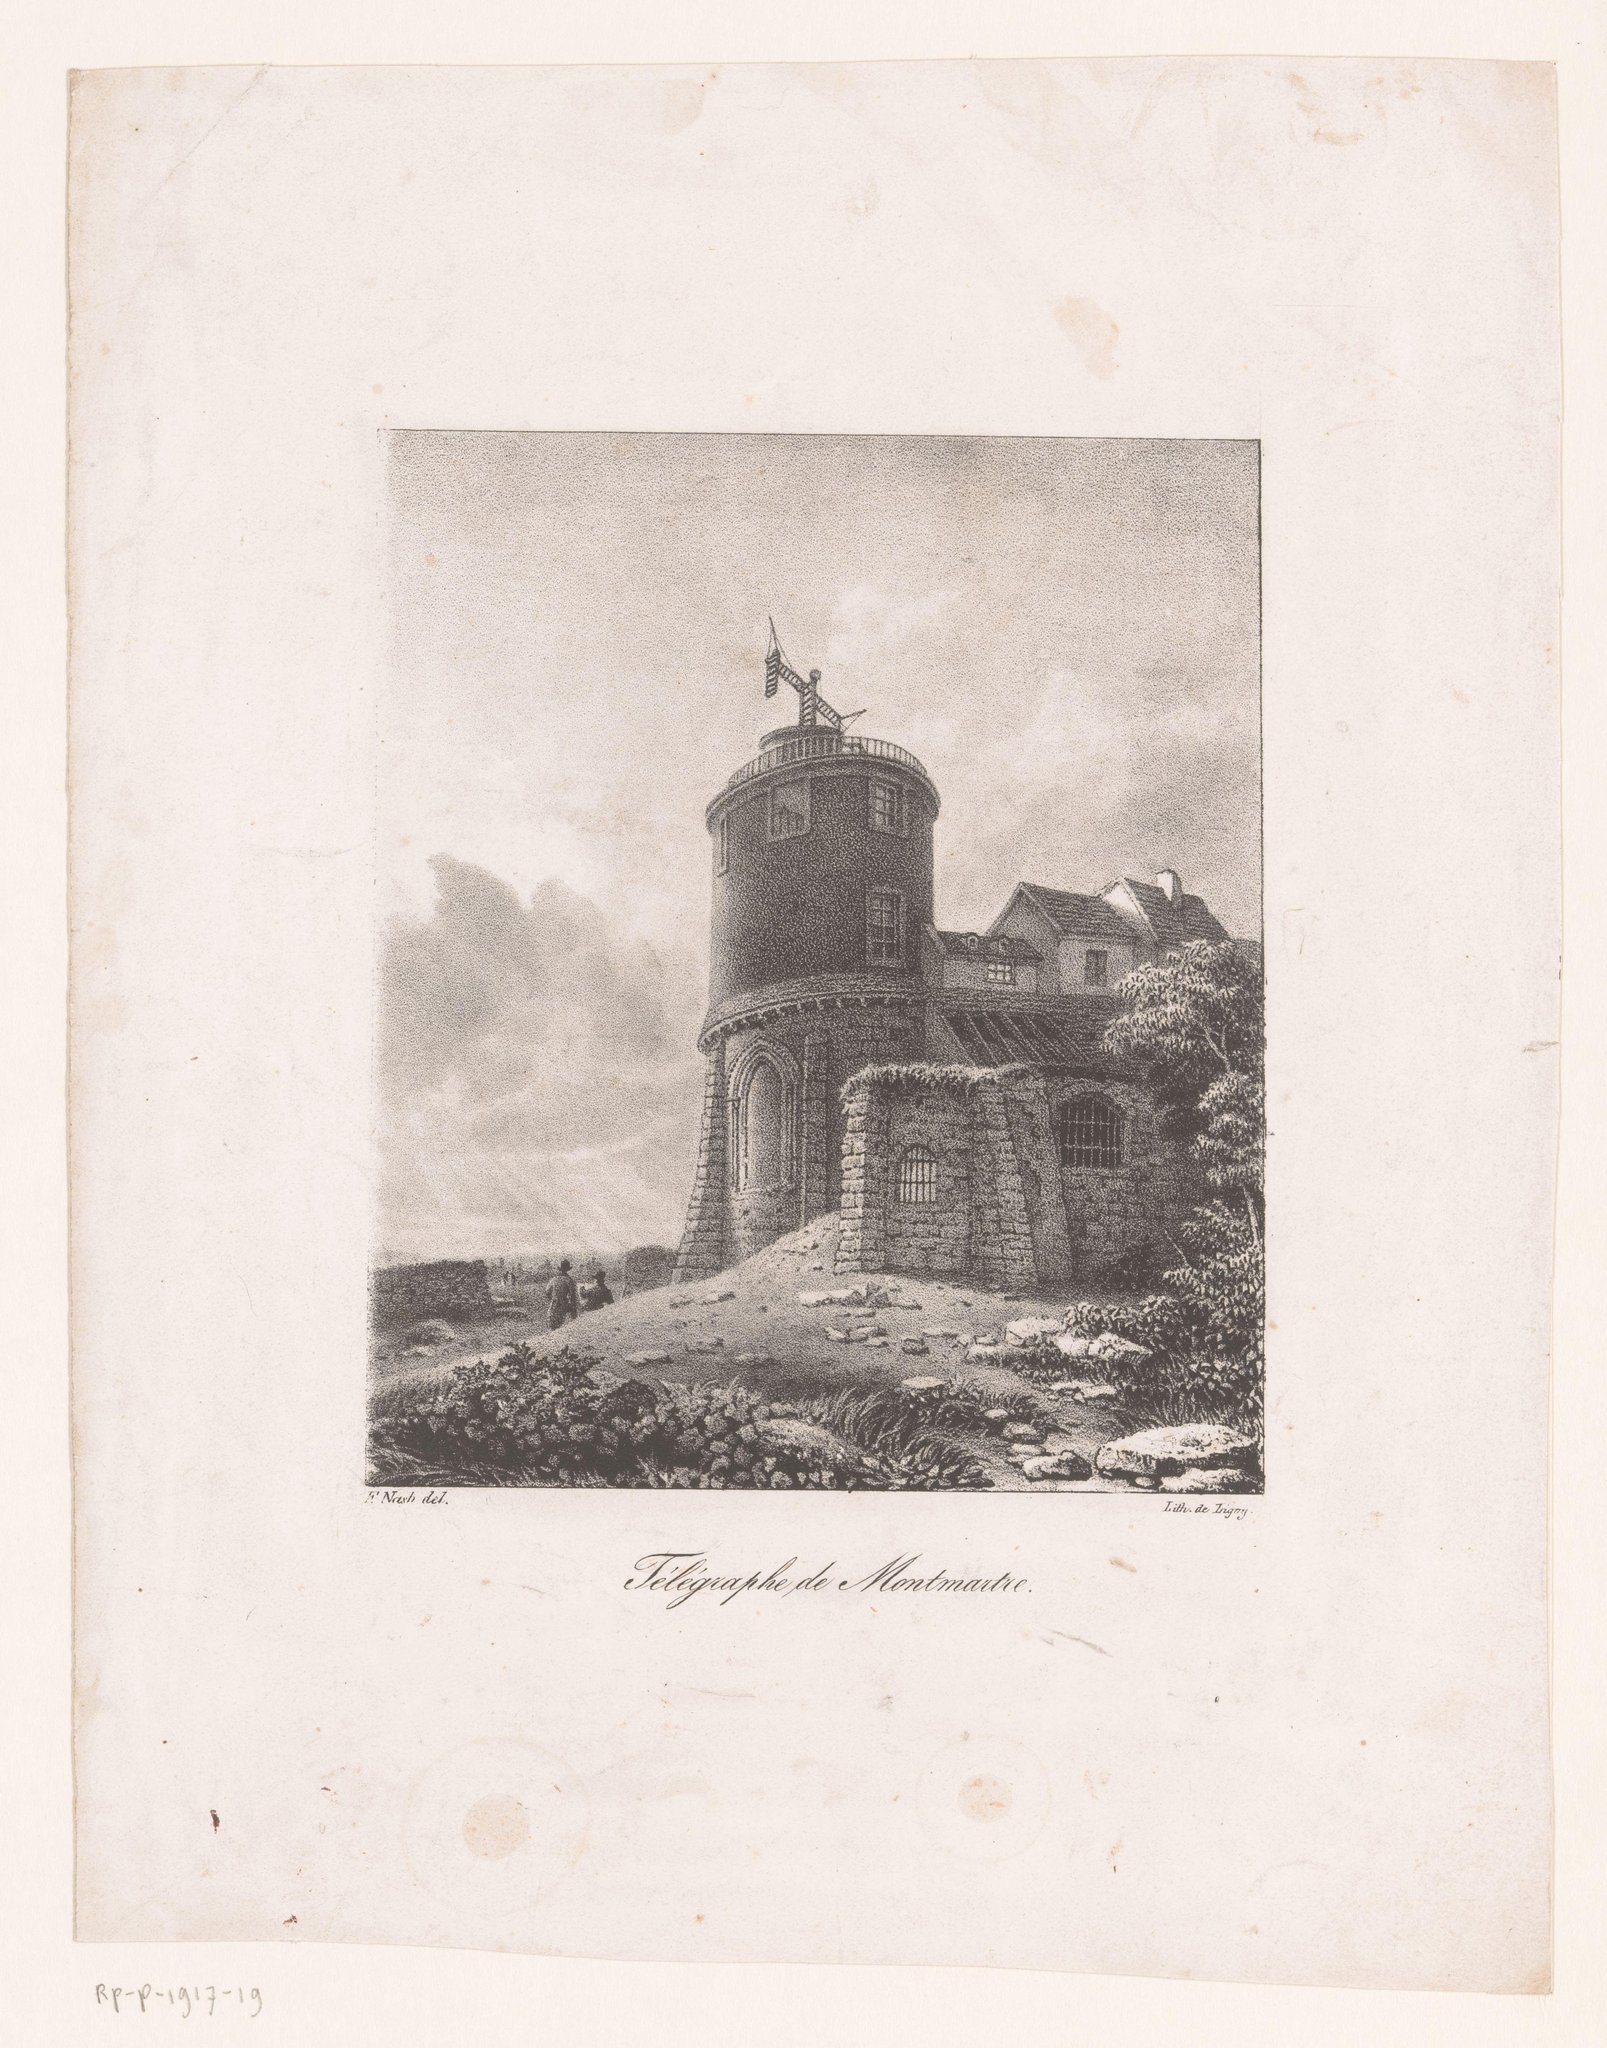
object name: print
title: Gezicht op de Télégraphe op Montmartre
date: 1798-1856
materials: paper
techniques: lithograph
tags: telegraph pole, telephone pole, paris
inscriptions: collector's mark: Lugt 2228